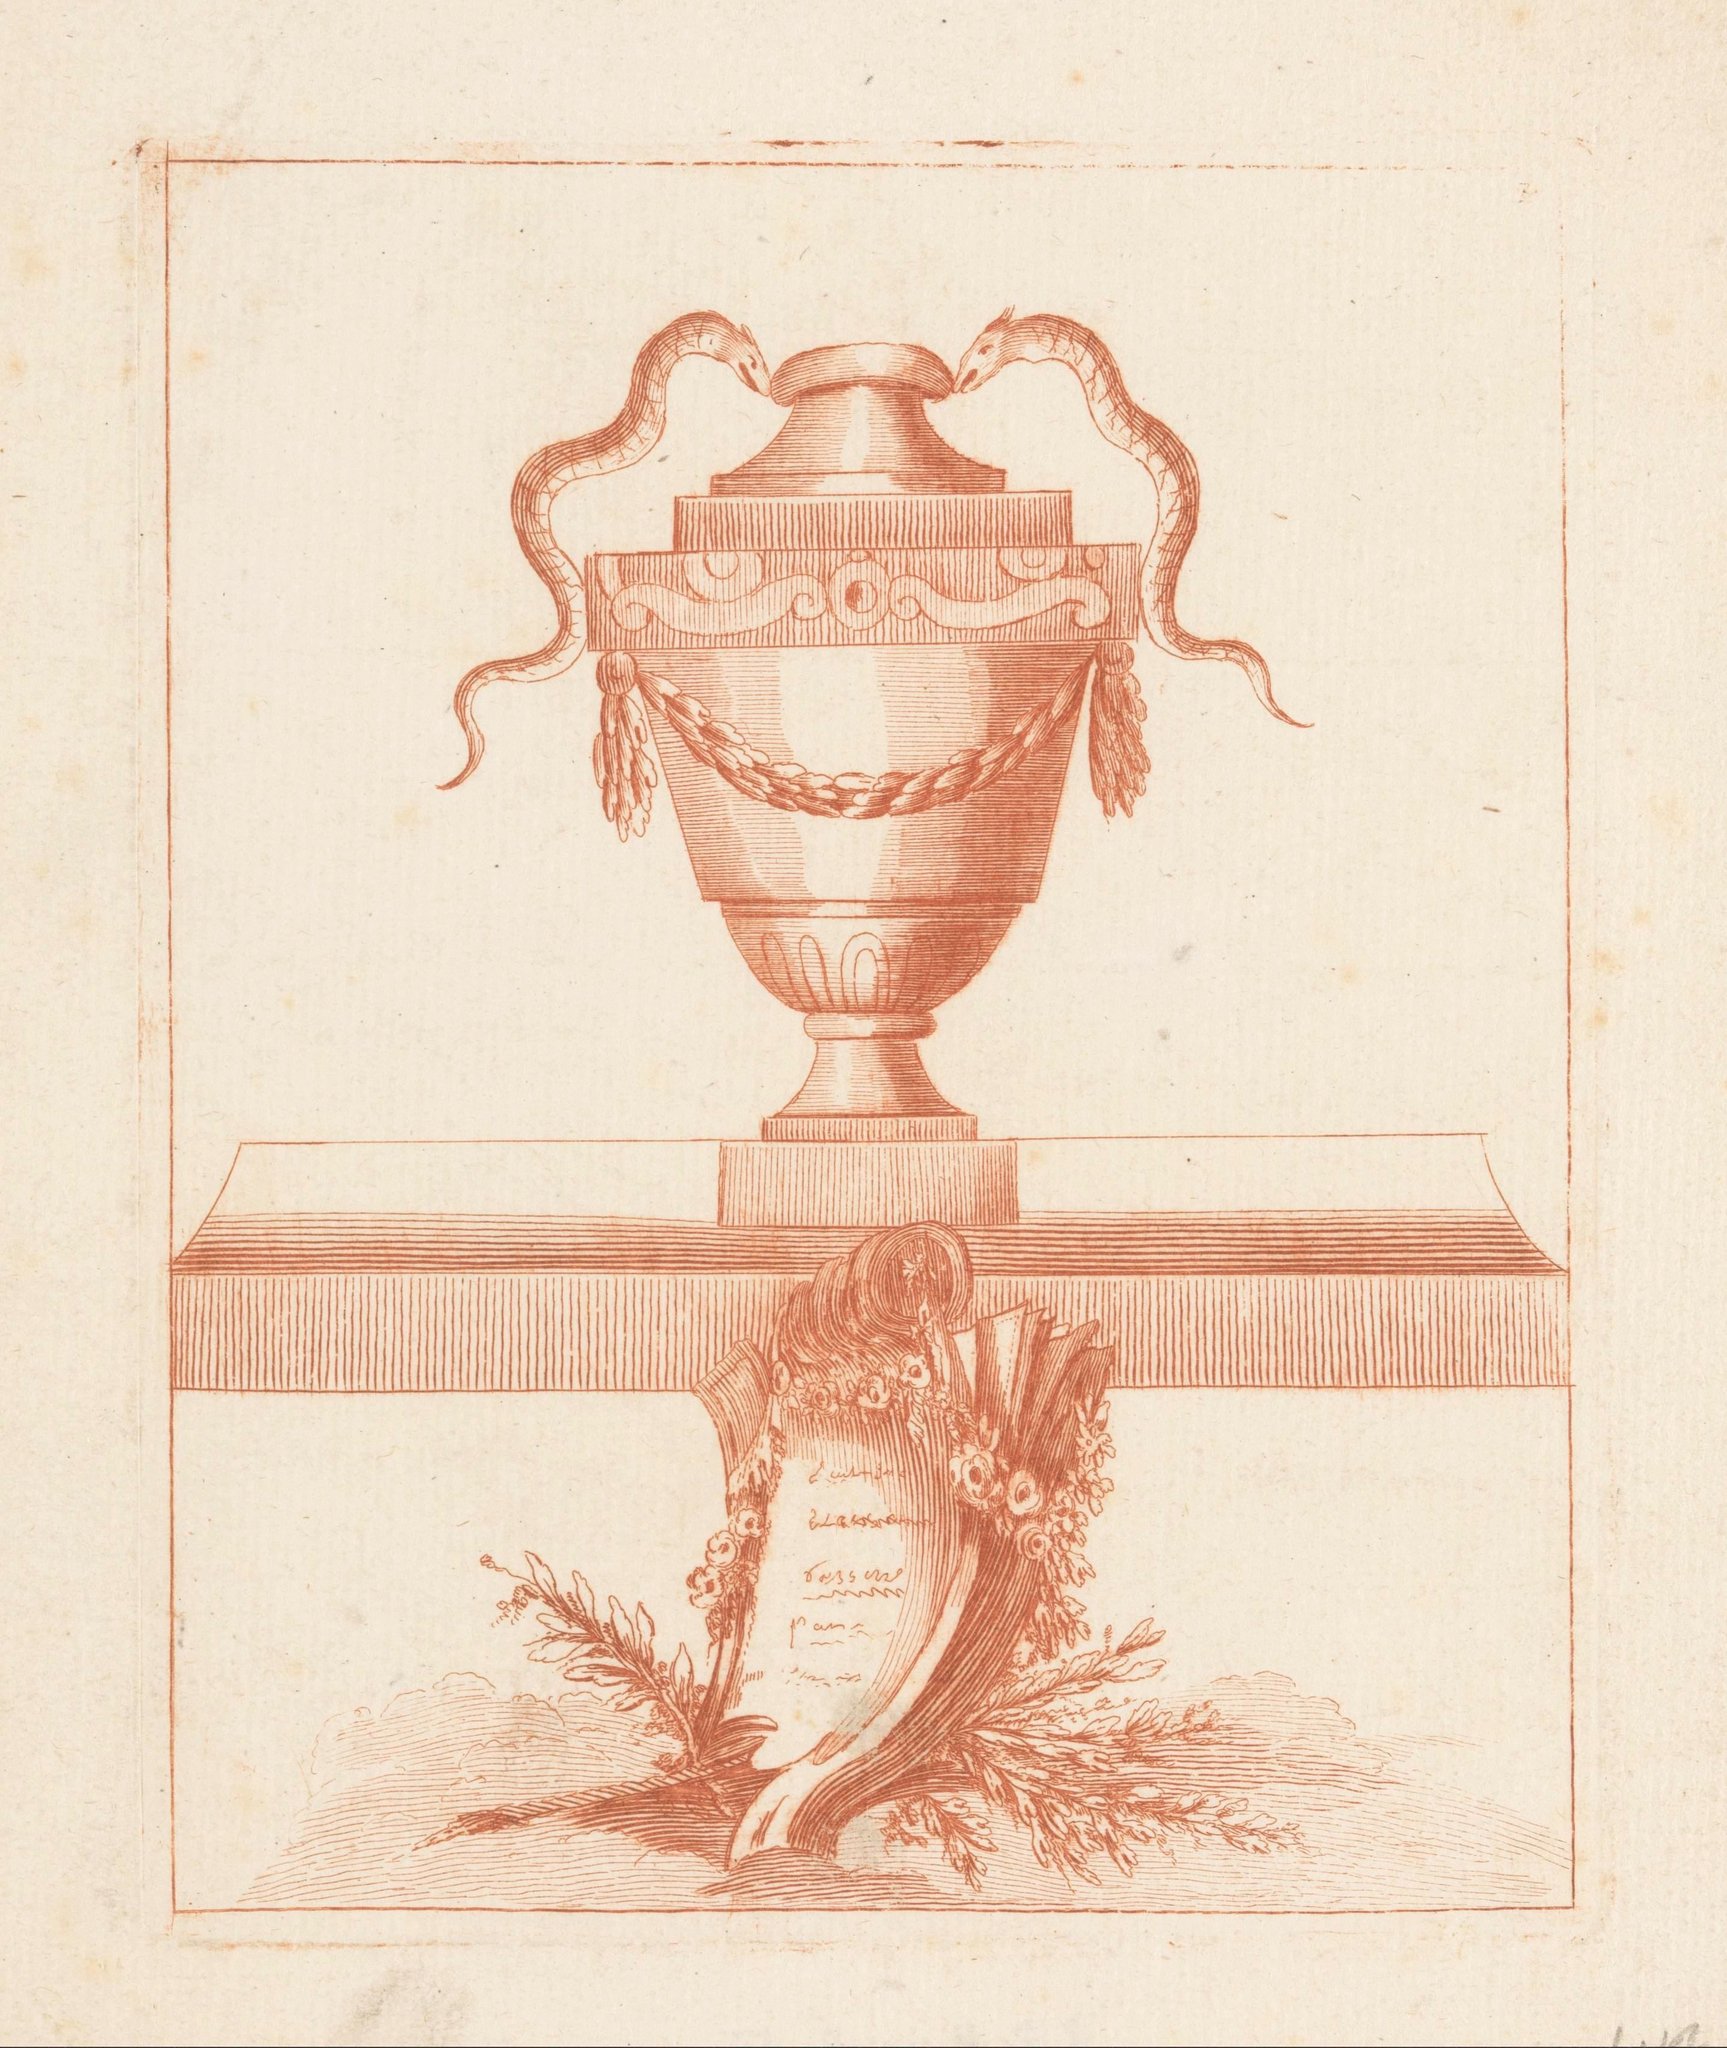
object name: ornament print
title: Vaas met slangen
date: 1770-1780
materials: paper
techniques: etching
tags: snakes, vase ~ ornament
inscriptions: collector's mark: Lugt 2228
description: Een geornamenteerde vaas met handvaten in de vorm van slangen. Daaronder een cartouche met takken. Rechts boven genummerd (vervaagd).